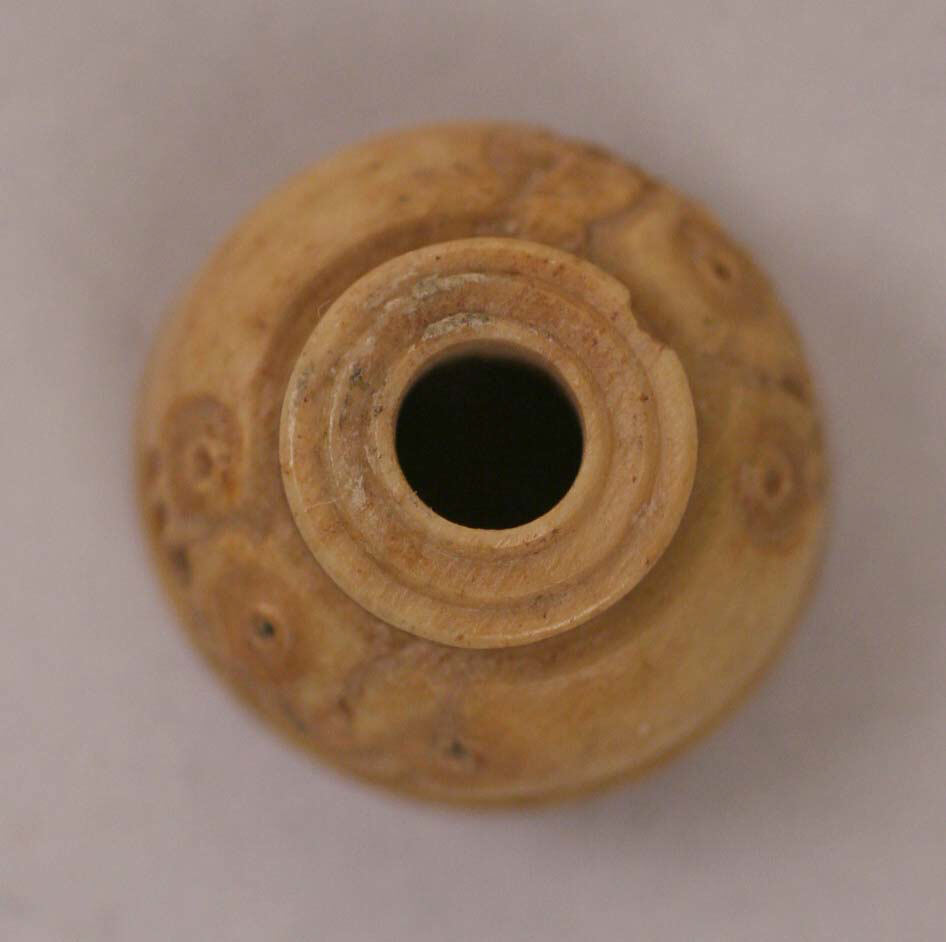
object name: button or bead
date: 801-1000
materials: bone, paint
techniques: incising, inlay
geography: iran